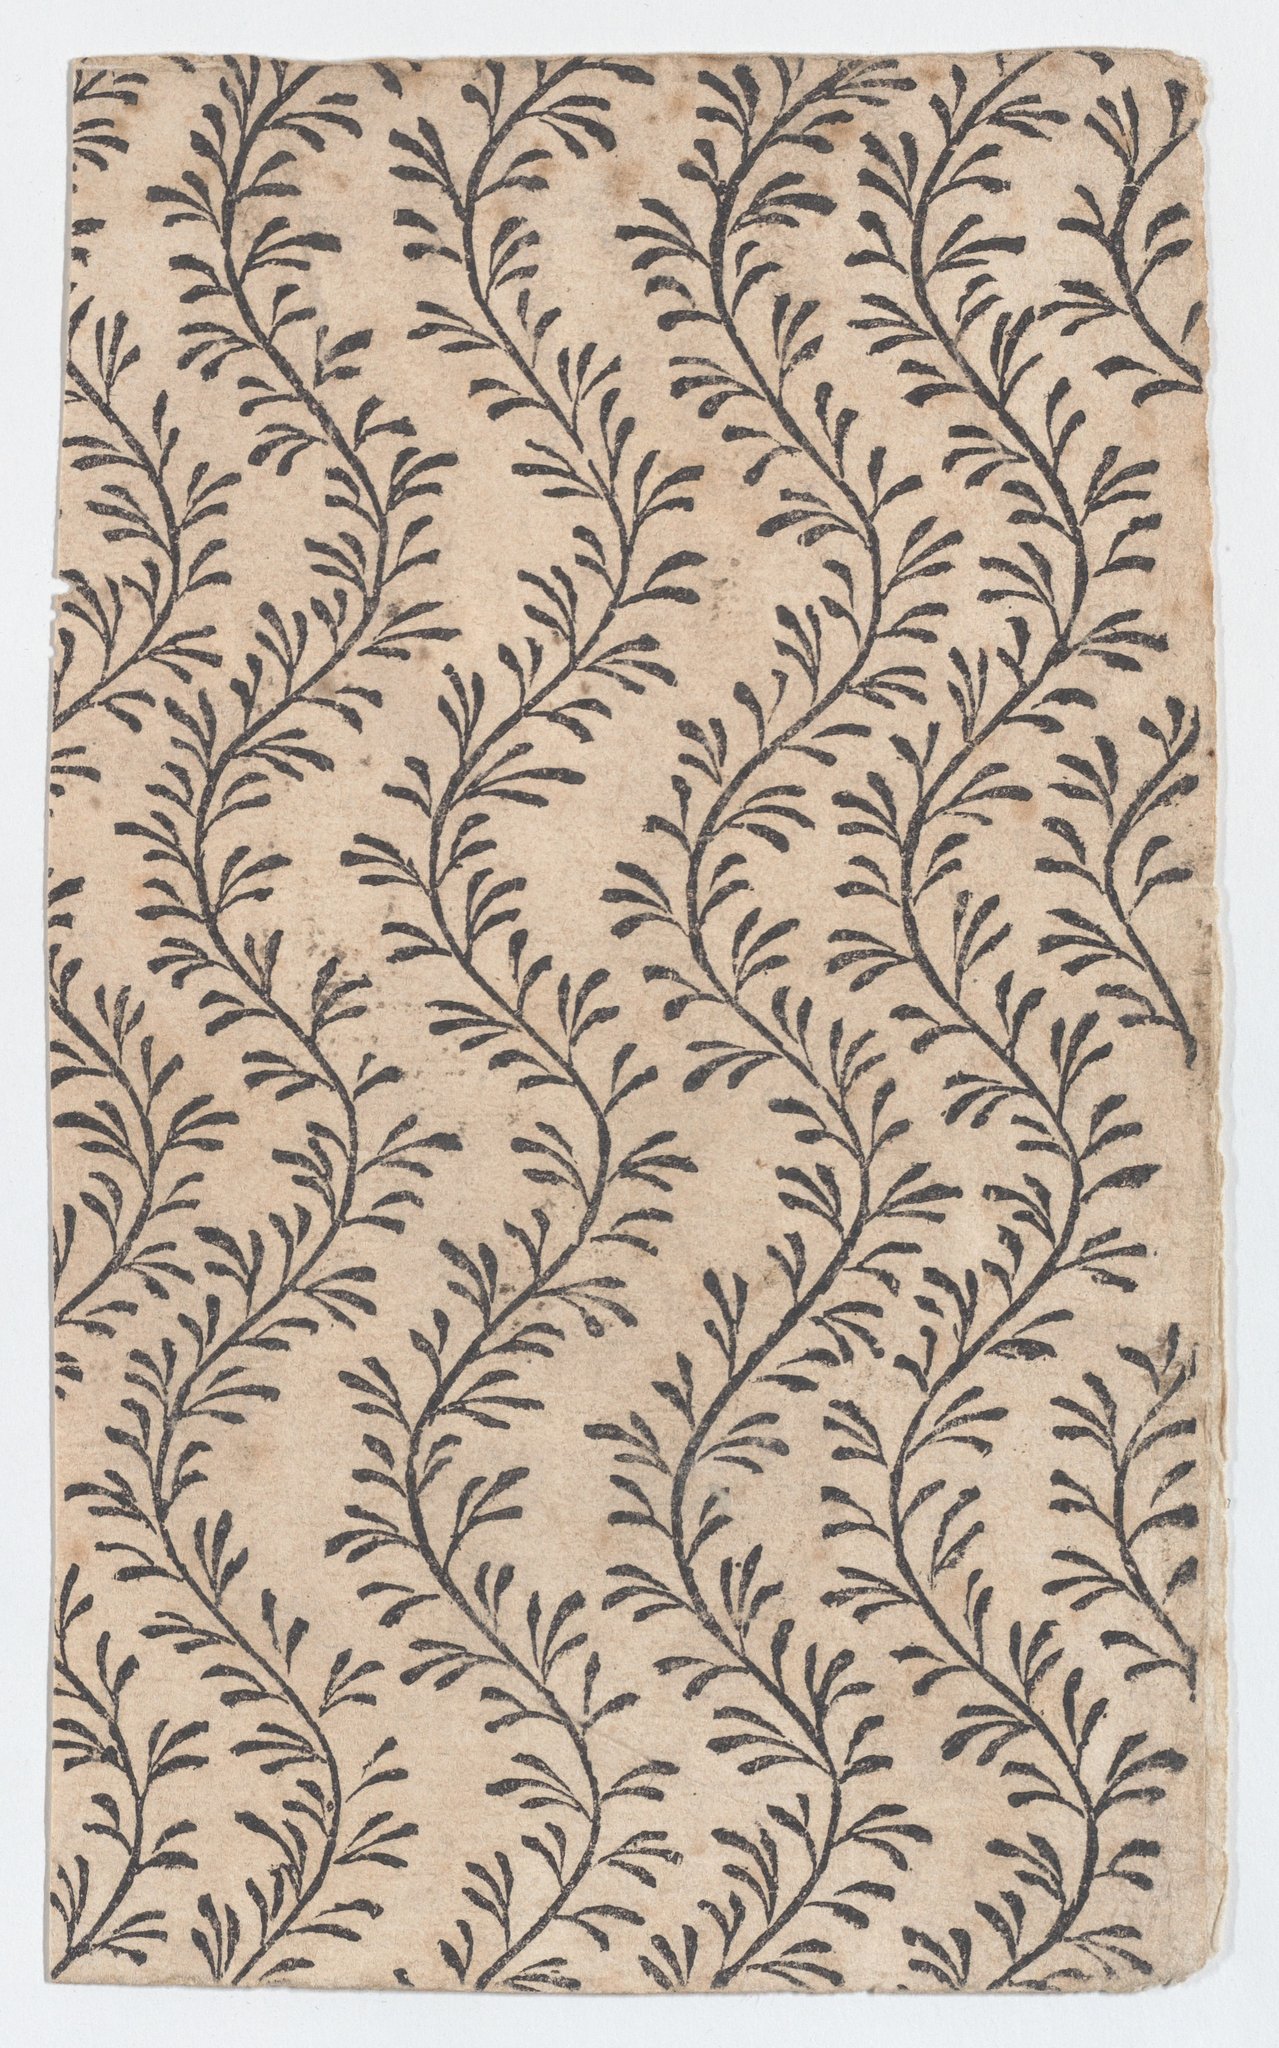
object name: print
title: Sheet with overall curved vine pattern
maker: Anonymous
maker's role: artist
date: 1801-1900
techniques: relief print